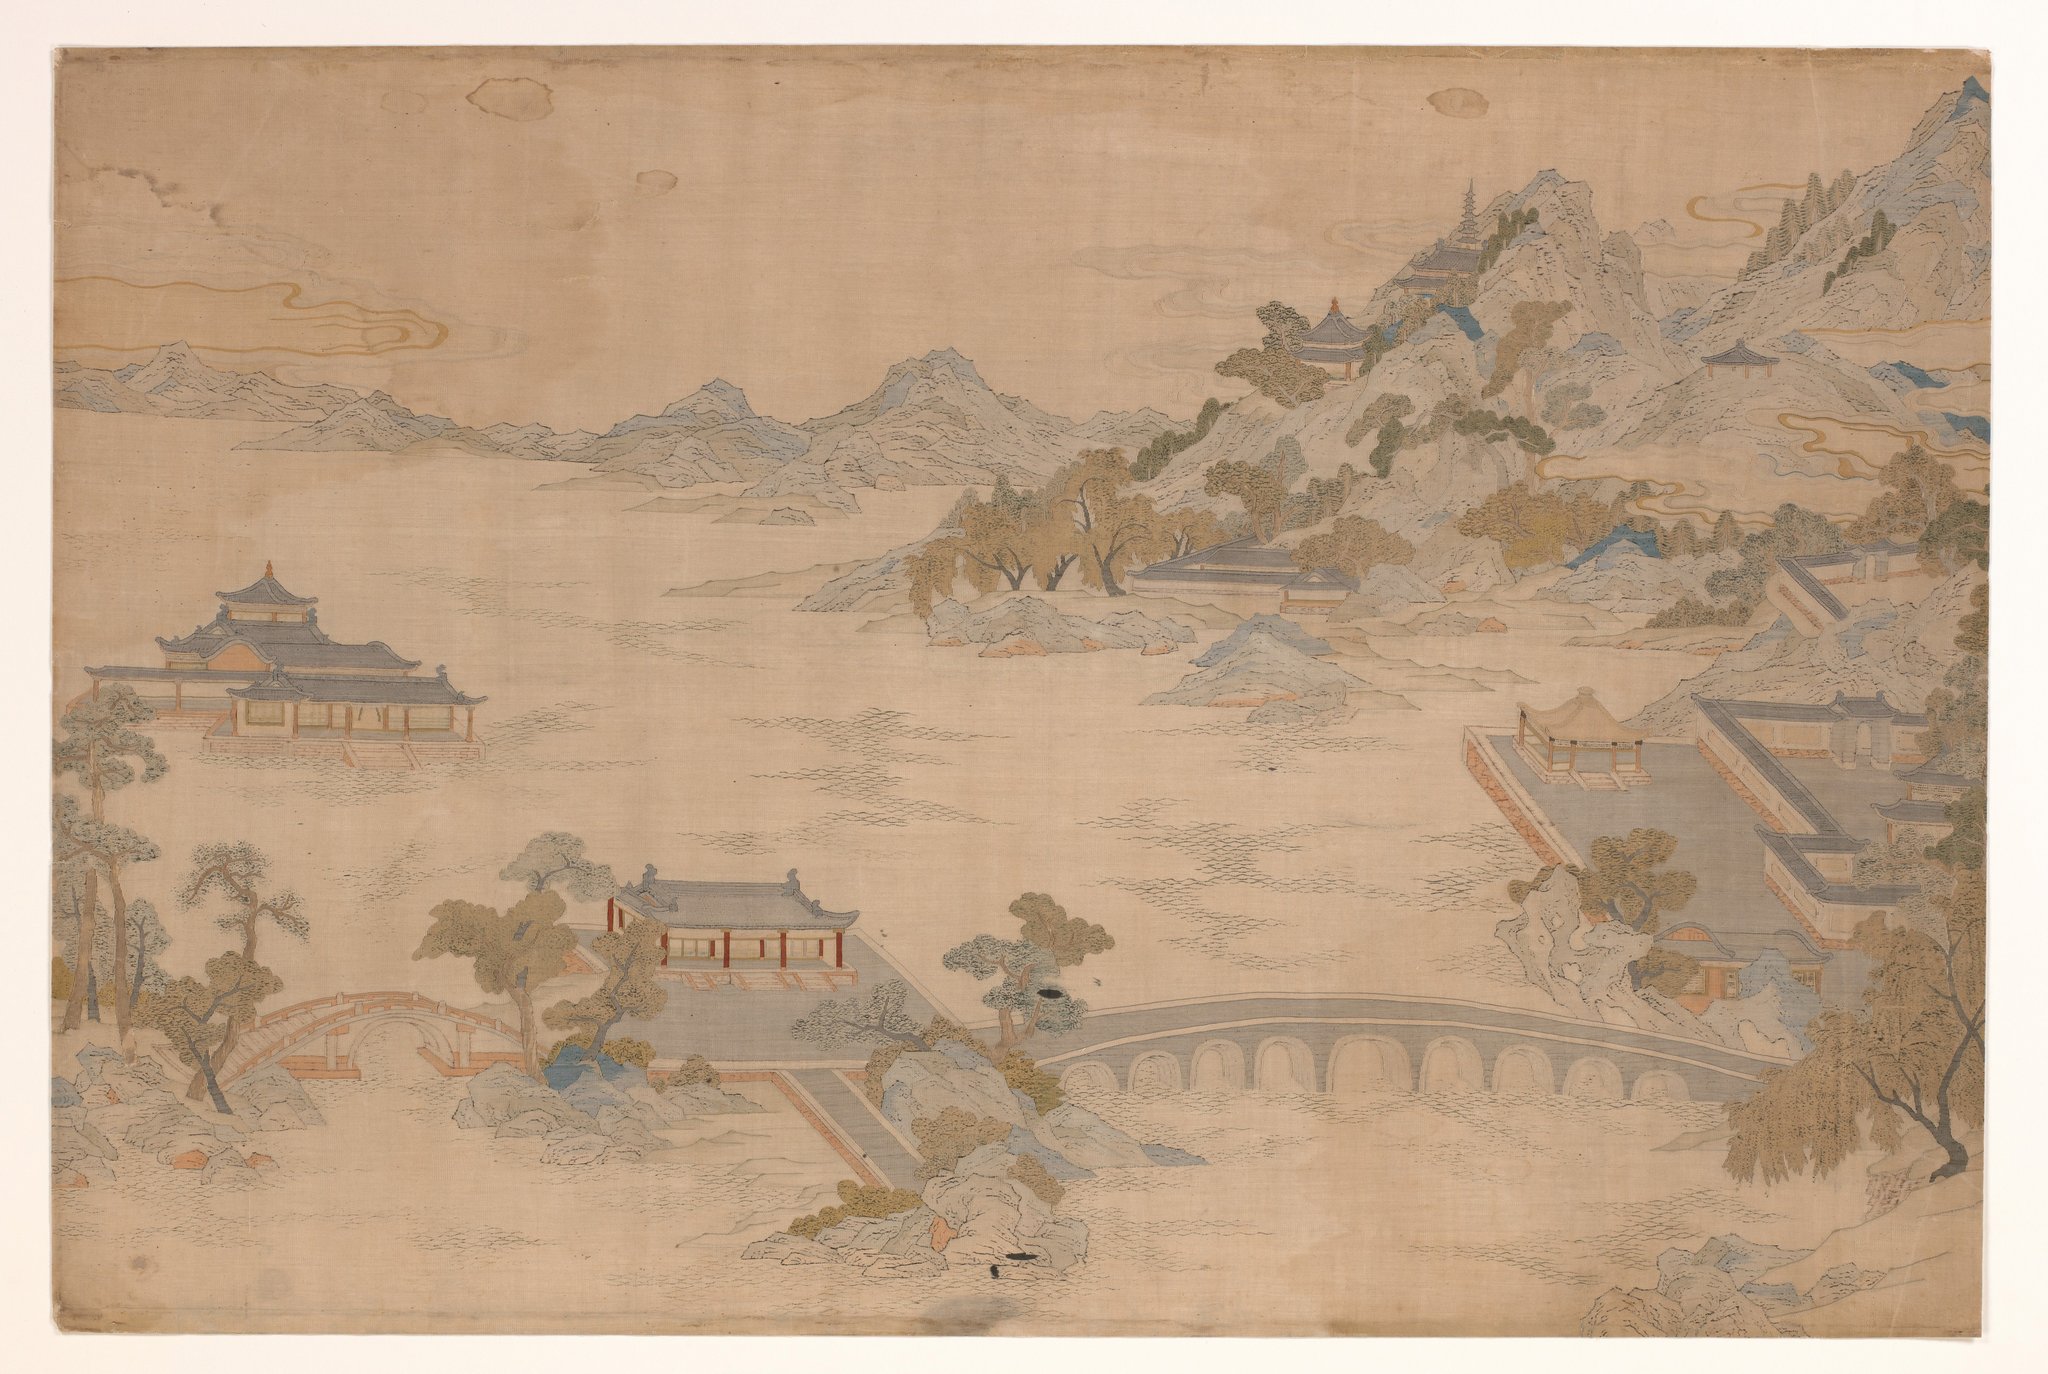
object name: panel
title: Panel with Landscape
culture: chinese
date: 1767-1800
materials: ink, metal thread, silk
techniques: tapestry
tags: bridges,hills,mountains,landscapes,pavilions